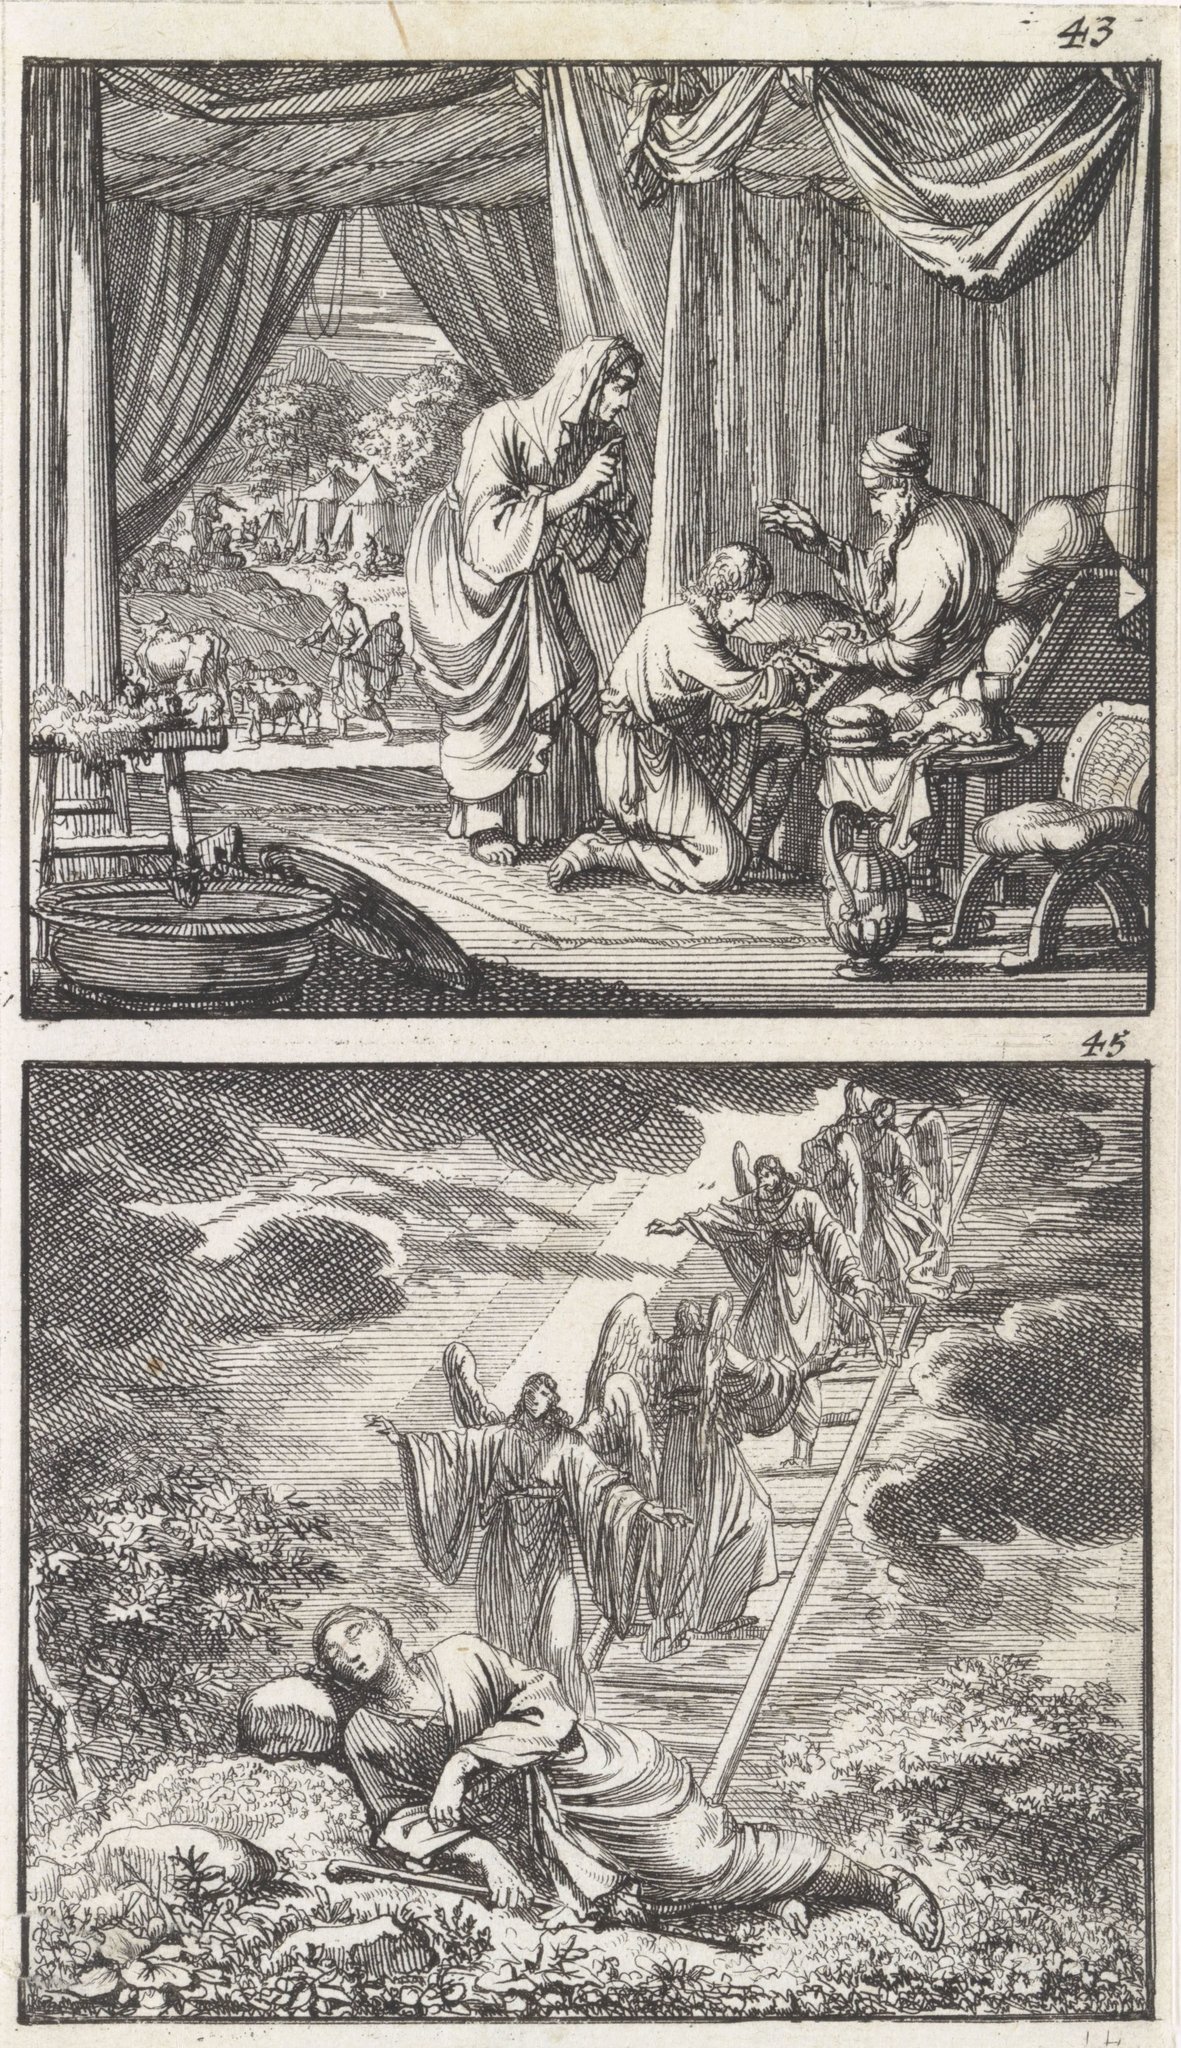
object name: print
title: Isaak zegent Jakob / Droom van Jakob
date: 1698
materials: paper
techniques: etching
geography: amsterdam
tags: isaac lying in bed blesses jacob who, disguised in esau's clothes, brings food to his father; jacob's hands and neck are covered with goatskins, the dream of jacob: while sleeping on the ground with a stone for pillow jacob sees a ladder reaching from earth to heaven with angels going up and down; usually with god at the top of the ladder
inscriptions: collector's mark: Lugt 2228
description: Illustraties uit: Josephus, Flavius. XX. boeken van de oude geschiedenissen der joden, 4 delen. Amsterdam: Barent Visscher, Willem de Coup, Willem van Lamsveld, Andries van Damme, 1698, dl. I.